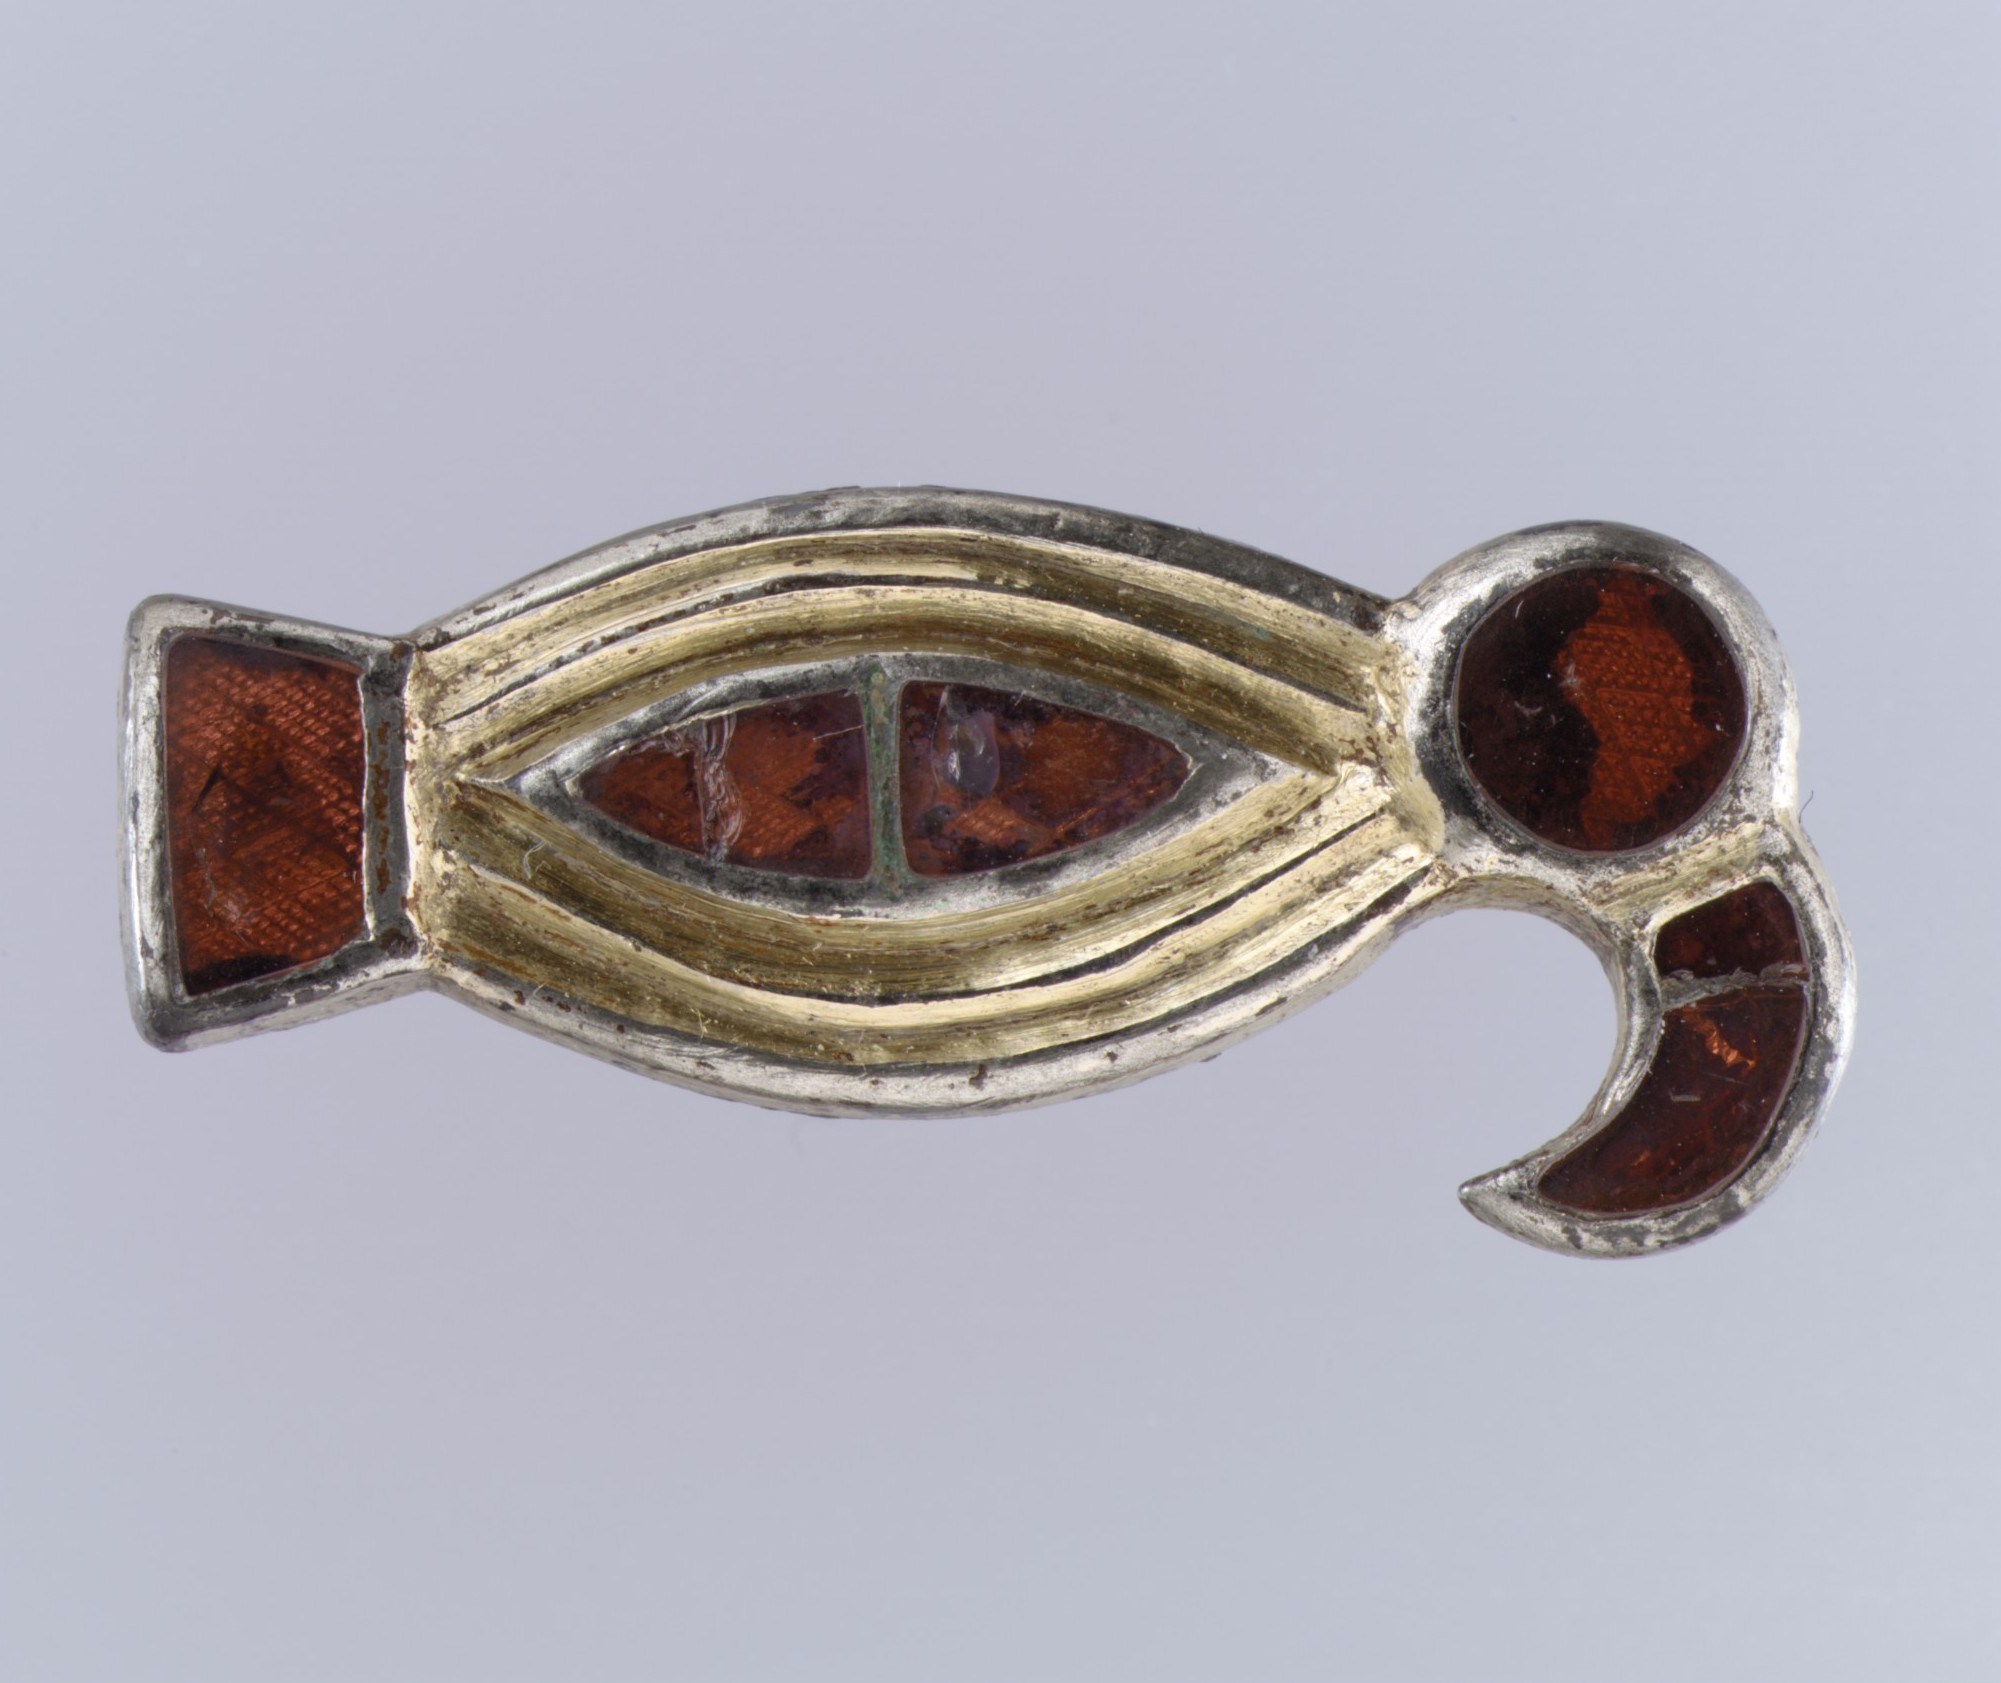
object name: brooch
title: Bird-Shaped Brooch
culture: frankish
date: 500-600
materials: foil, garnet, silver gilt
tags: birds